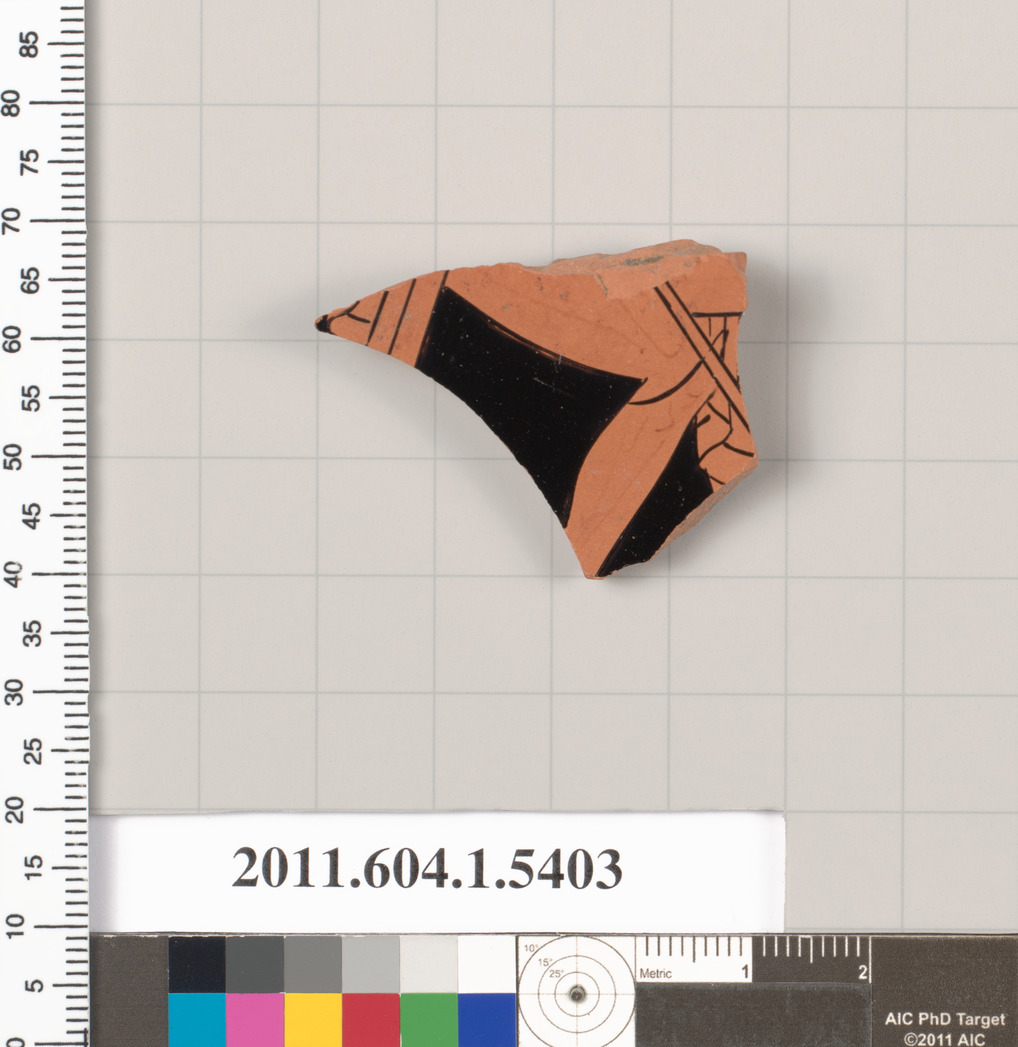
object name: kylix fragment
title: Terracotta fragment of a kylix (drinking cup)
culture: greek, attic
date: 500-480 BCE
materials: terracotta